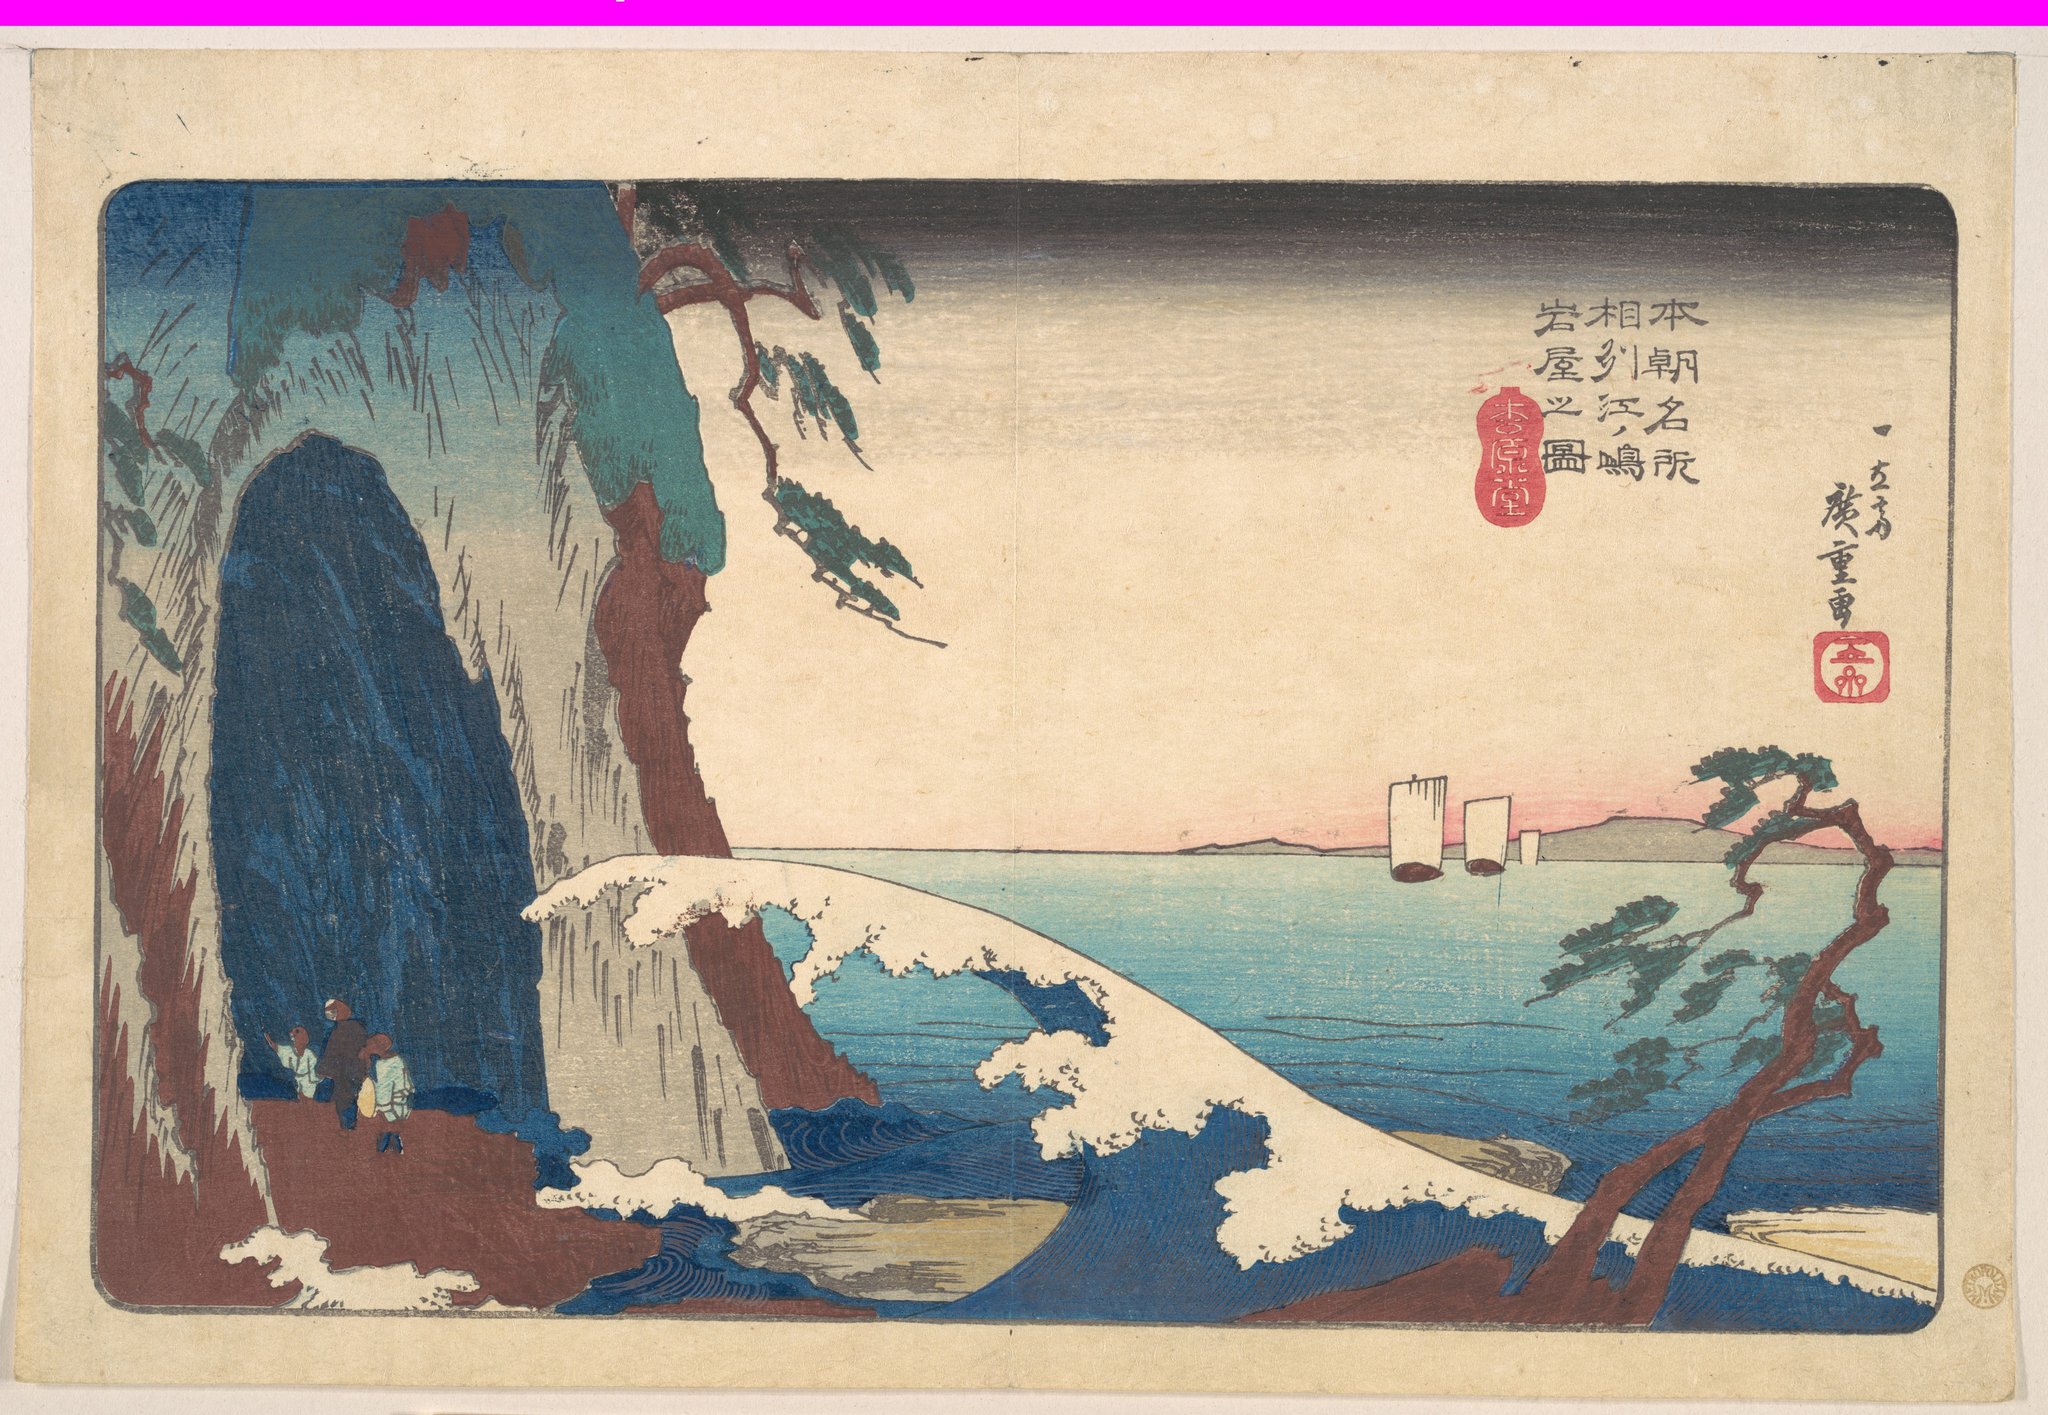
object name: print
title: Soshu, Enoshima Iwaya no Zu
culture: japanese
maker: utagawa hiroshige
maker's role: artist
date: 1830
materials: ink, paper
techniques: woodblock print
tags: caves,waves,boats